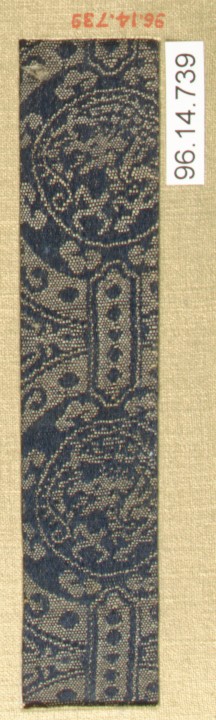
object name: piece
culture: japanese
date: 1701-1900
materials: silk